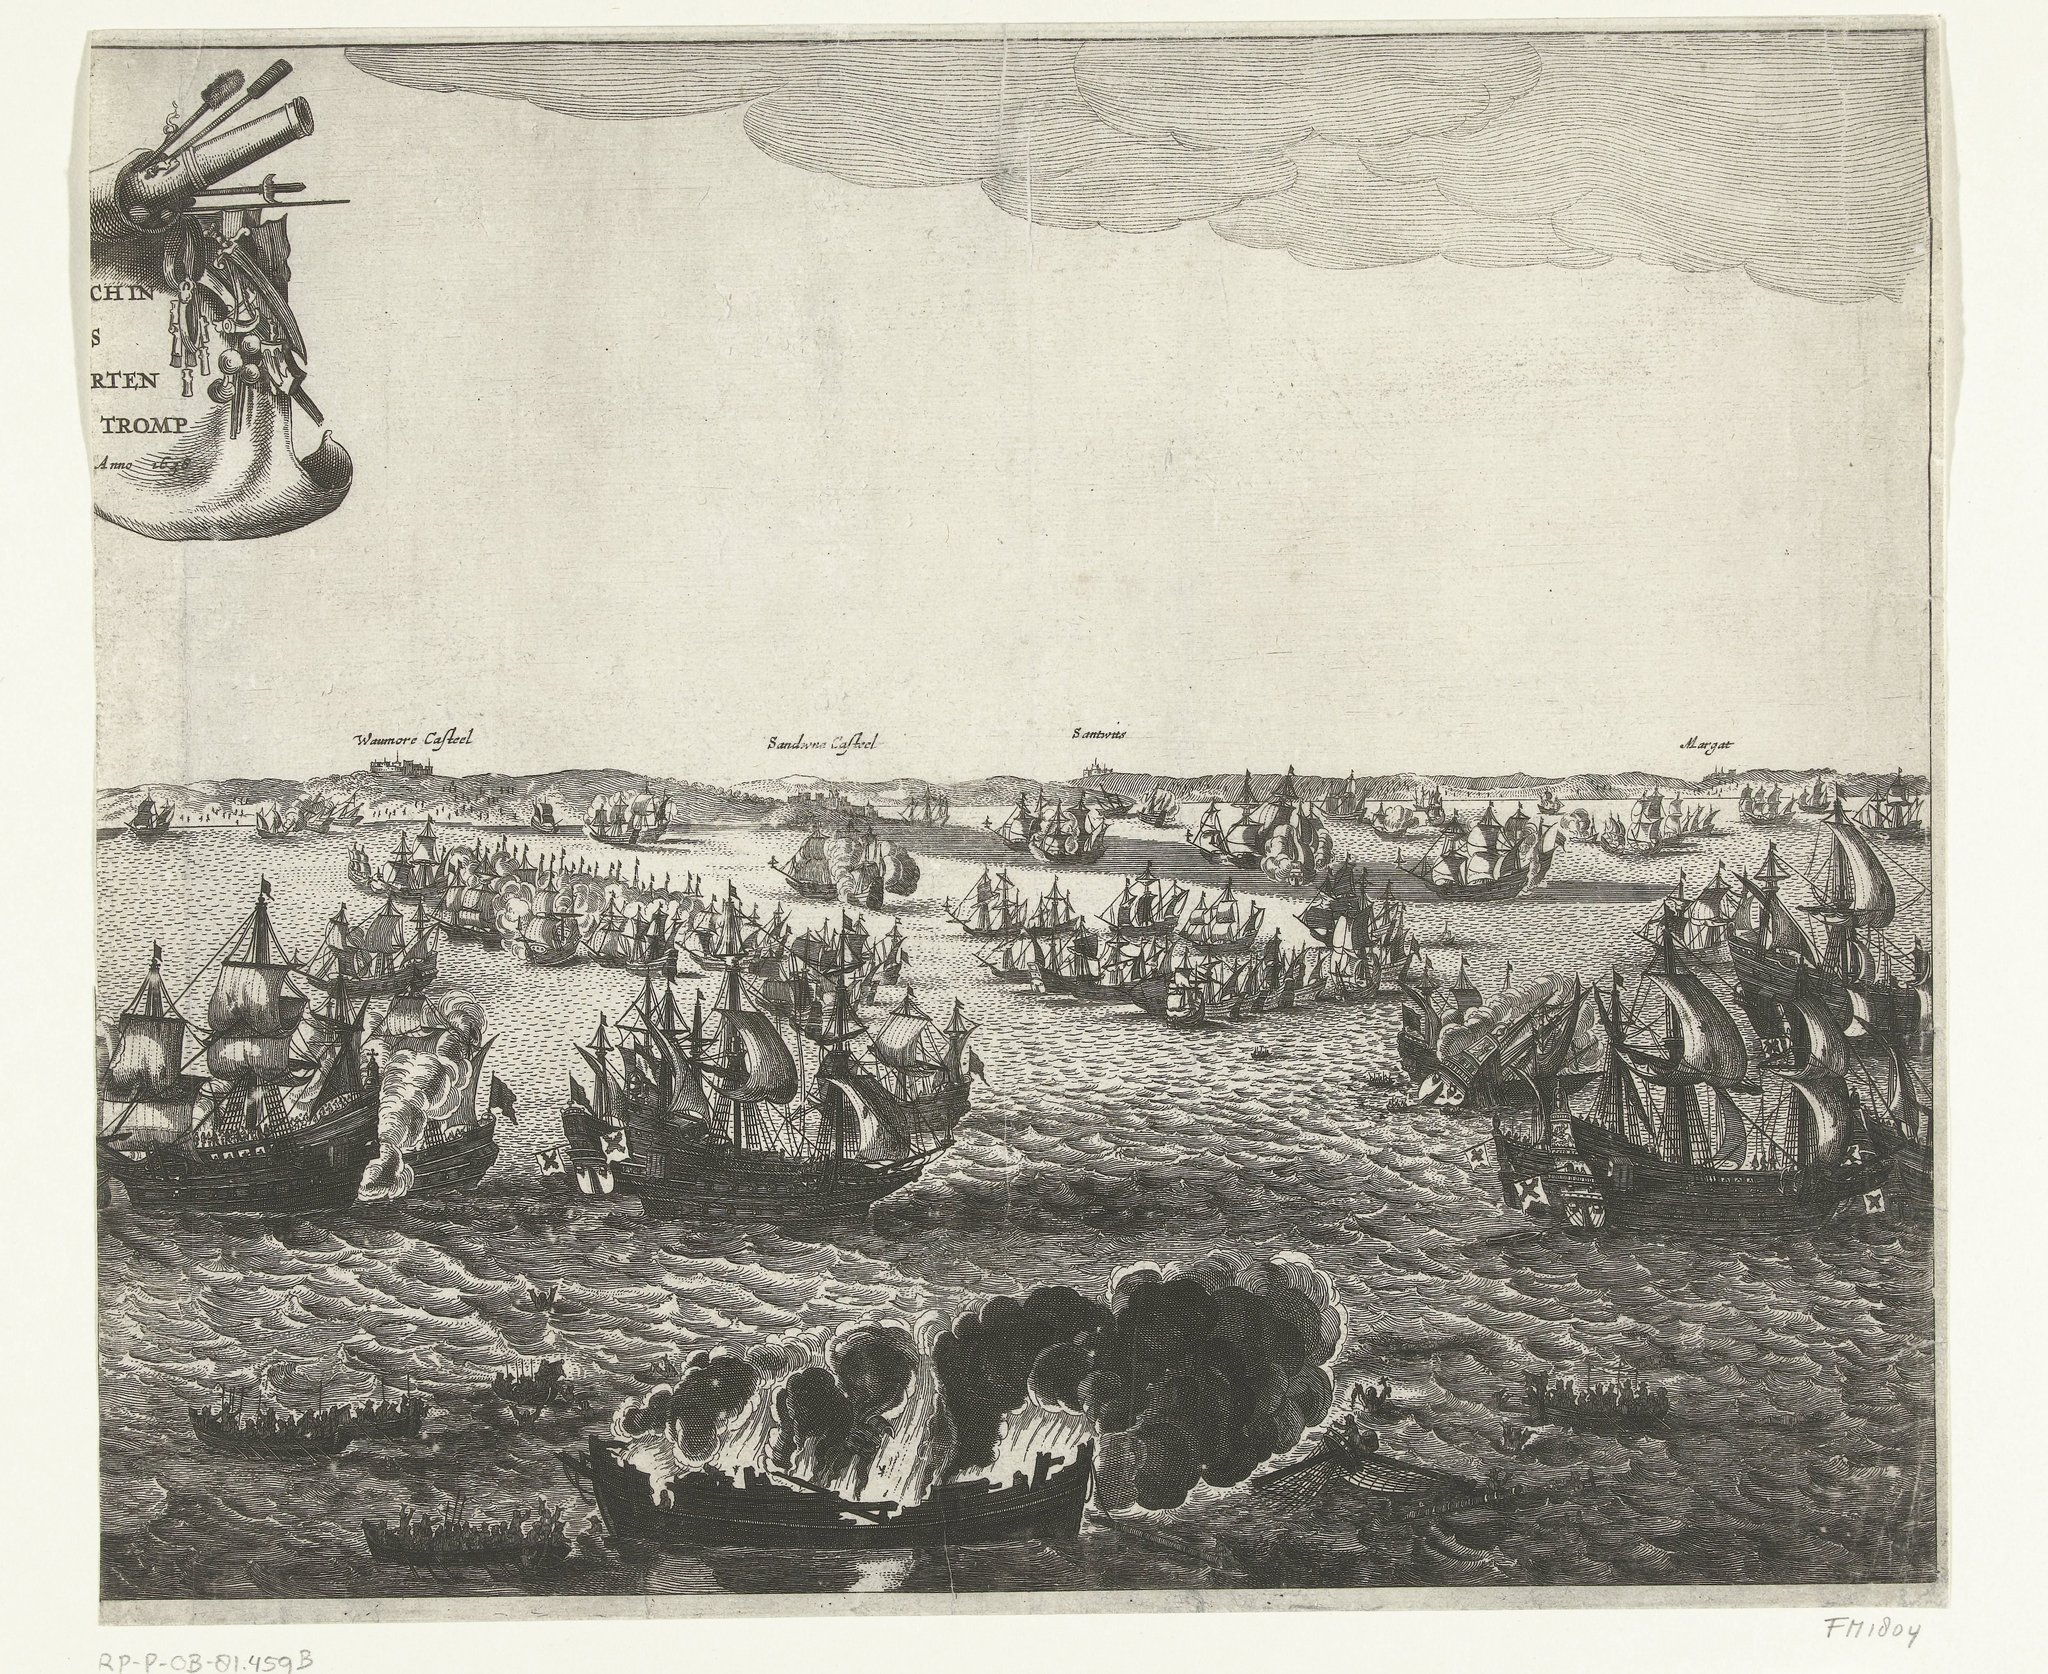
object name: print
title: Zeeschlach in Duyns door Marten Harpers Tromp den 21 October Anno 1638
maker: Anonymous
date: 1649-1651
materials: paper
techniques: etching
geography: northern netherlands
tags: maarten harpertszoon tromp, battle (+ naval force), battle of the downs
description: Zeeslag bij Duins tussen de Spaanse vloot onder bevel van Antonio de Oquendo en de Staatse vloot onder Maarten Harpertsz. Tromp, 21 oktober 1639. Rechterplaat met op de voorgrond een brandend schip en sloepen met bemanningsleden, rechts de veroverde Spaanse schepen. Op de achtergrond de Engelse kust tussen Walmer en Margate. Bovenaan in het midden een cartouche met de titel (gedeeld).